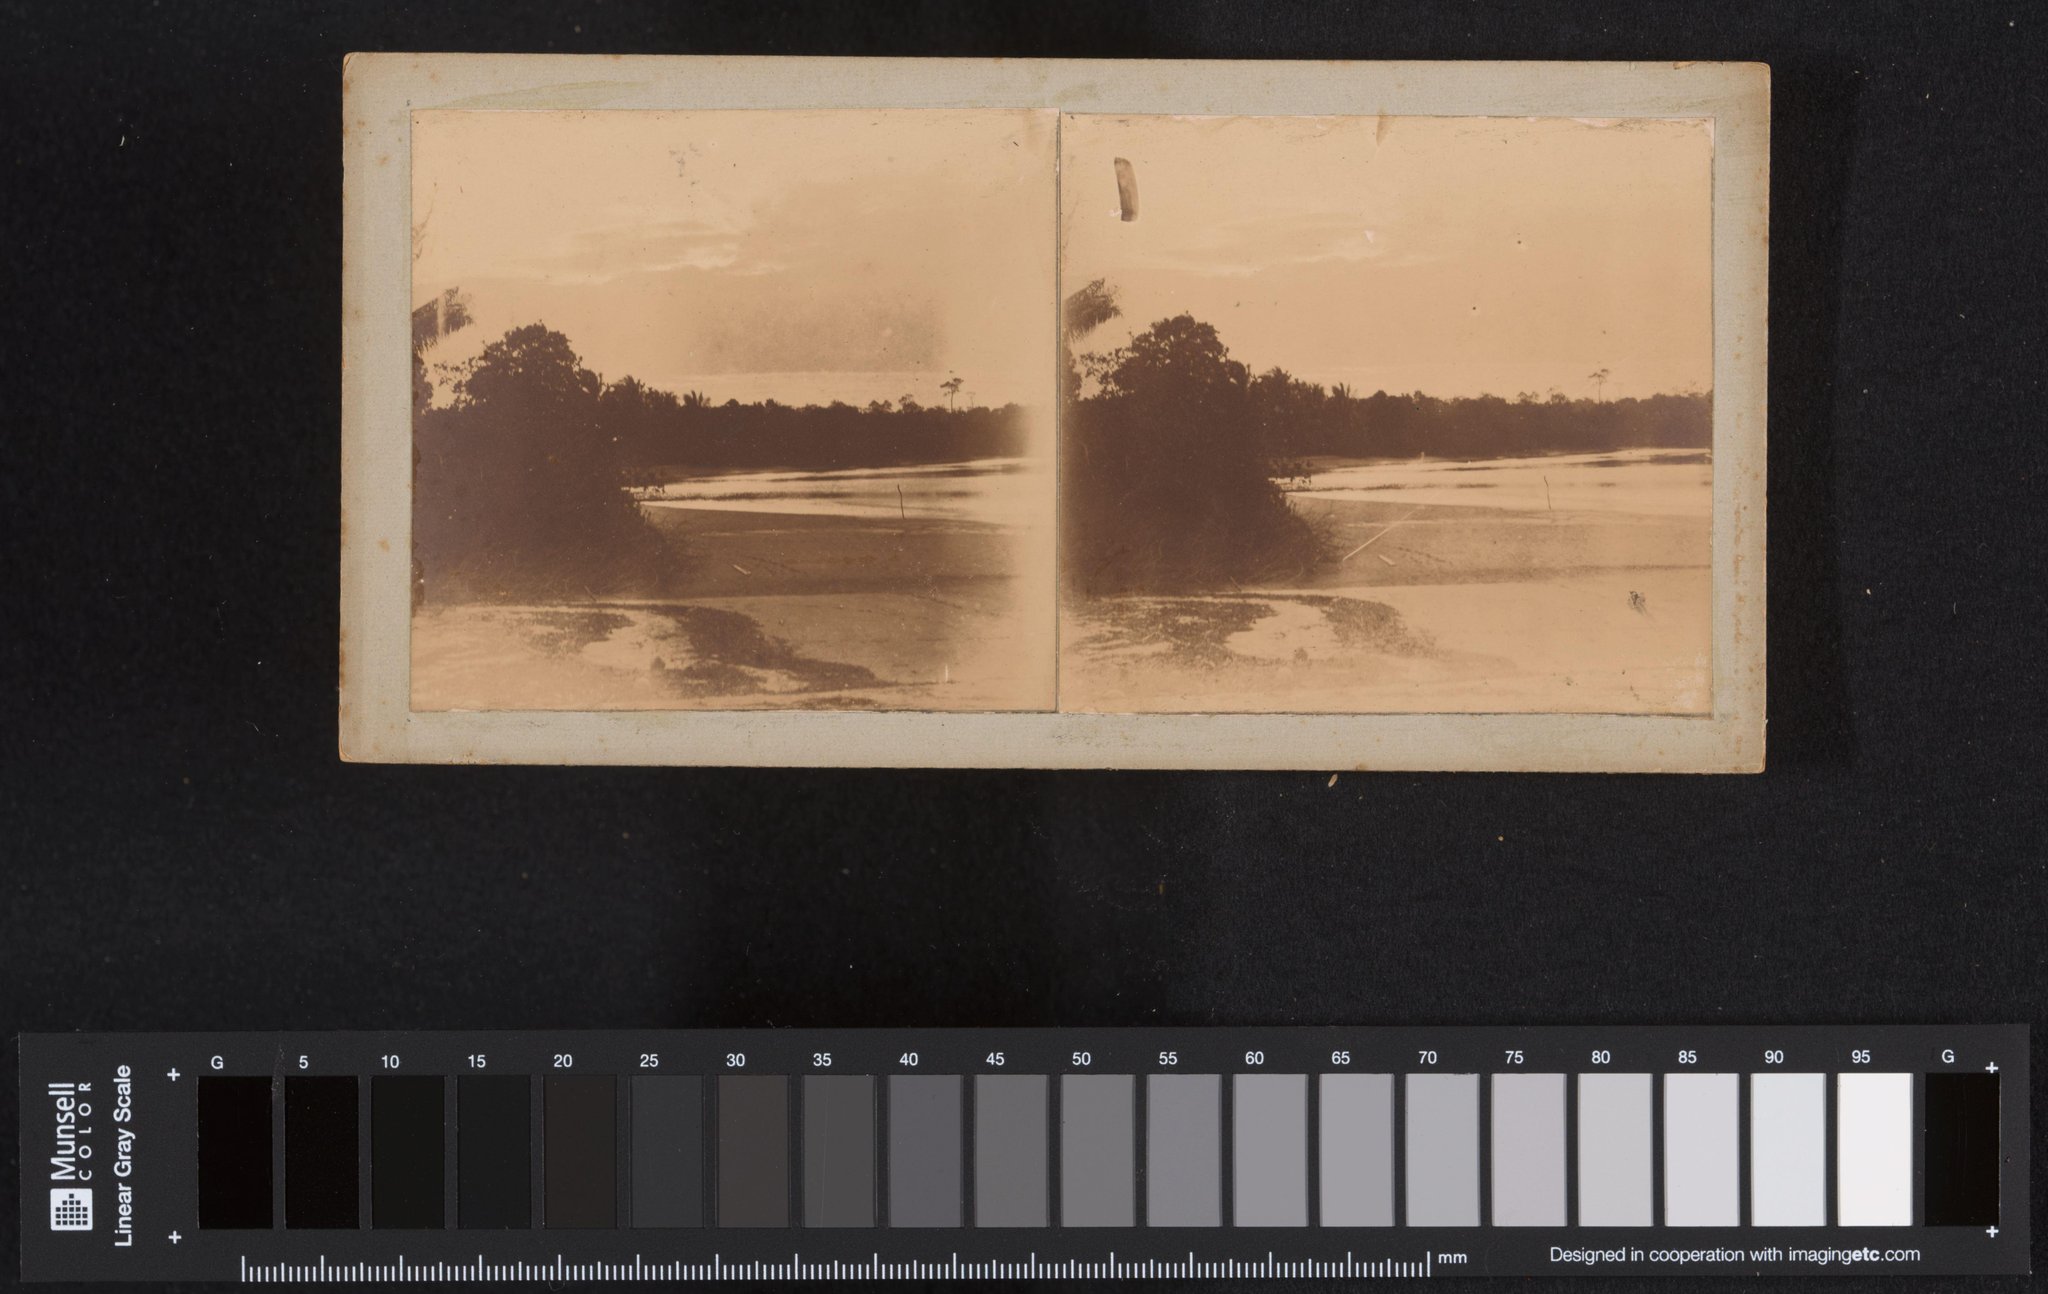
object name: stereograph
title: Riviermonding in zee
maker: robert julius boers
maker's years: 1867-1932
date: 1900-1922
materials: cardboard, photographic support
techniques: gelatin silver print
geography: bangka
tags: robert julius boers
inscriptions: inscription: ‘Monding der Soengei kiat rivier bij zonsondergang’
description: Gezicht op de monding van de rivier in zee bij zonsondergang, bij Soengeiliat op Banka. Onderdeel van een groep stereofoto's van Robert Julius Boers, chef van het staatsbedrijf de Banka-tinwinning op Banka, uit de periode ca. 1900-1922.